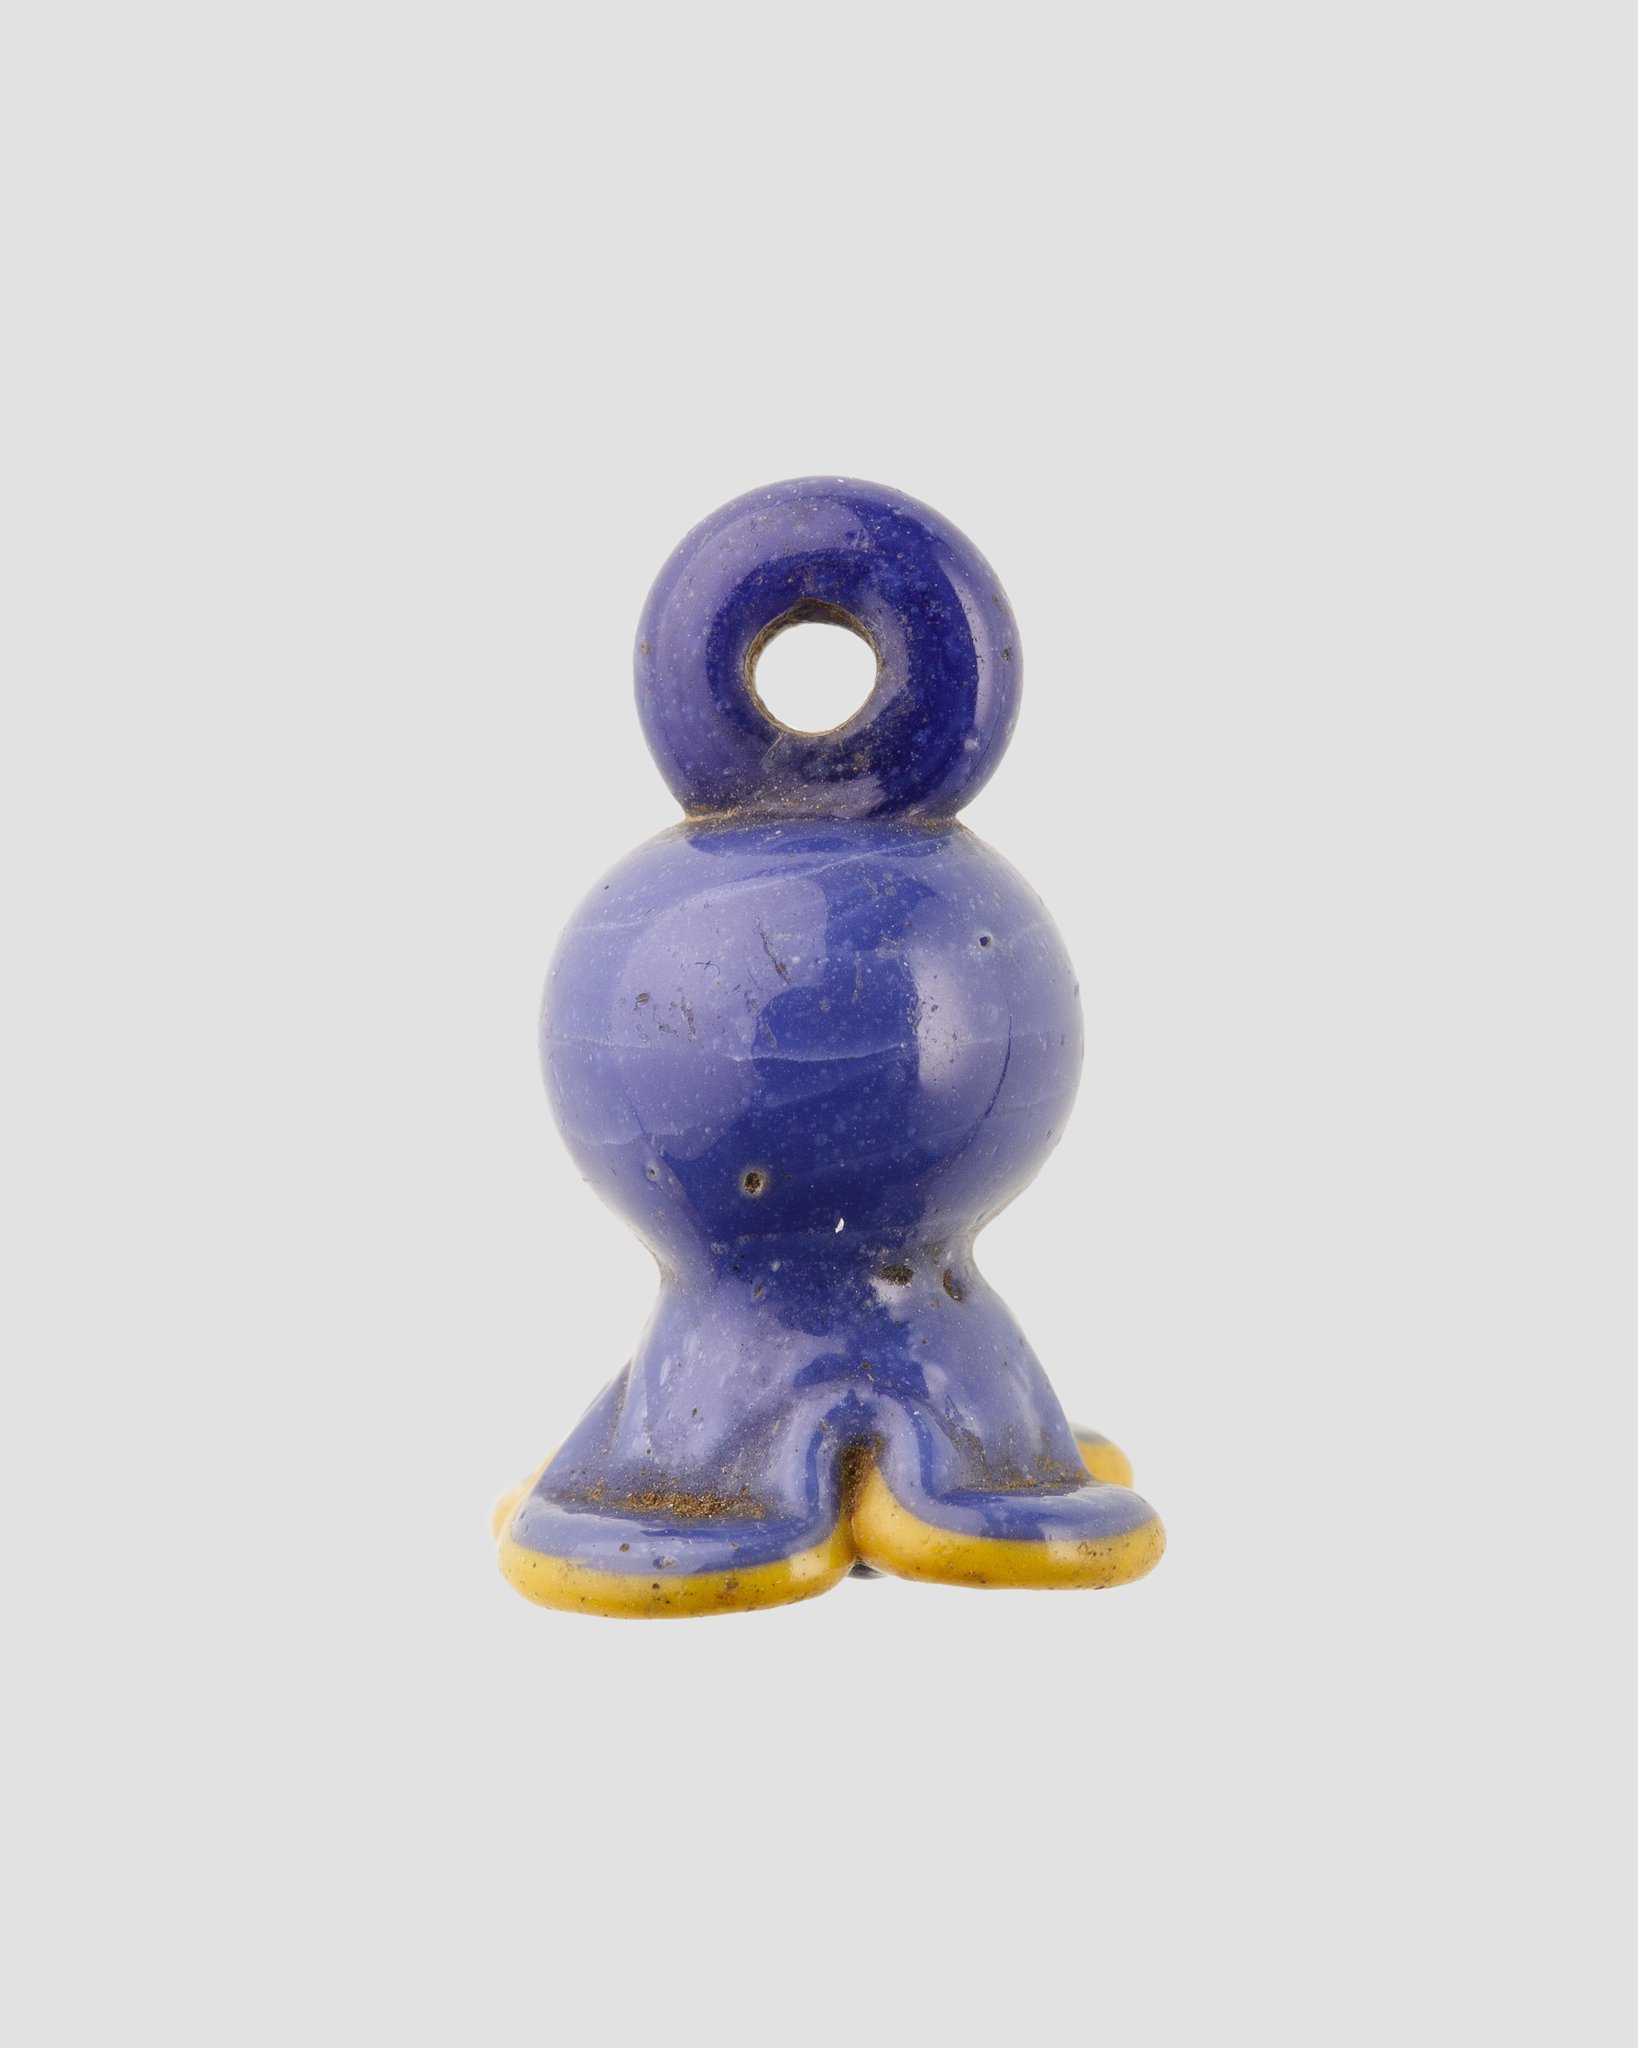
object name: pendant, pomegranate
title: Pendant in the Shape of a Pomegranate Flower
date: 1350-1295 BCE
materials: glass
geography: egypt